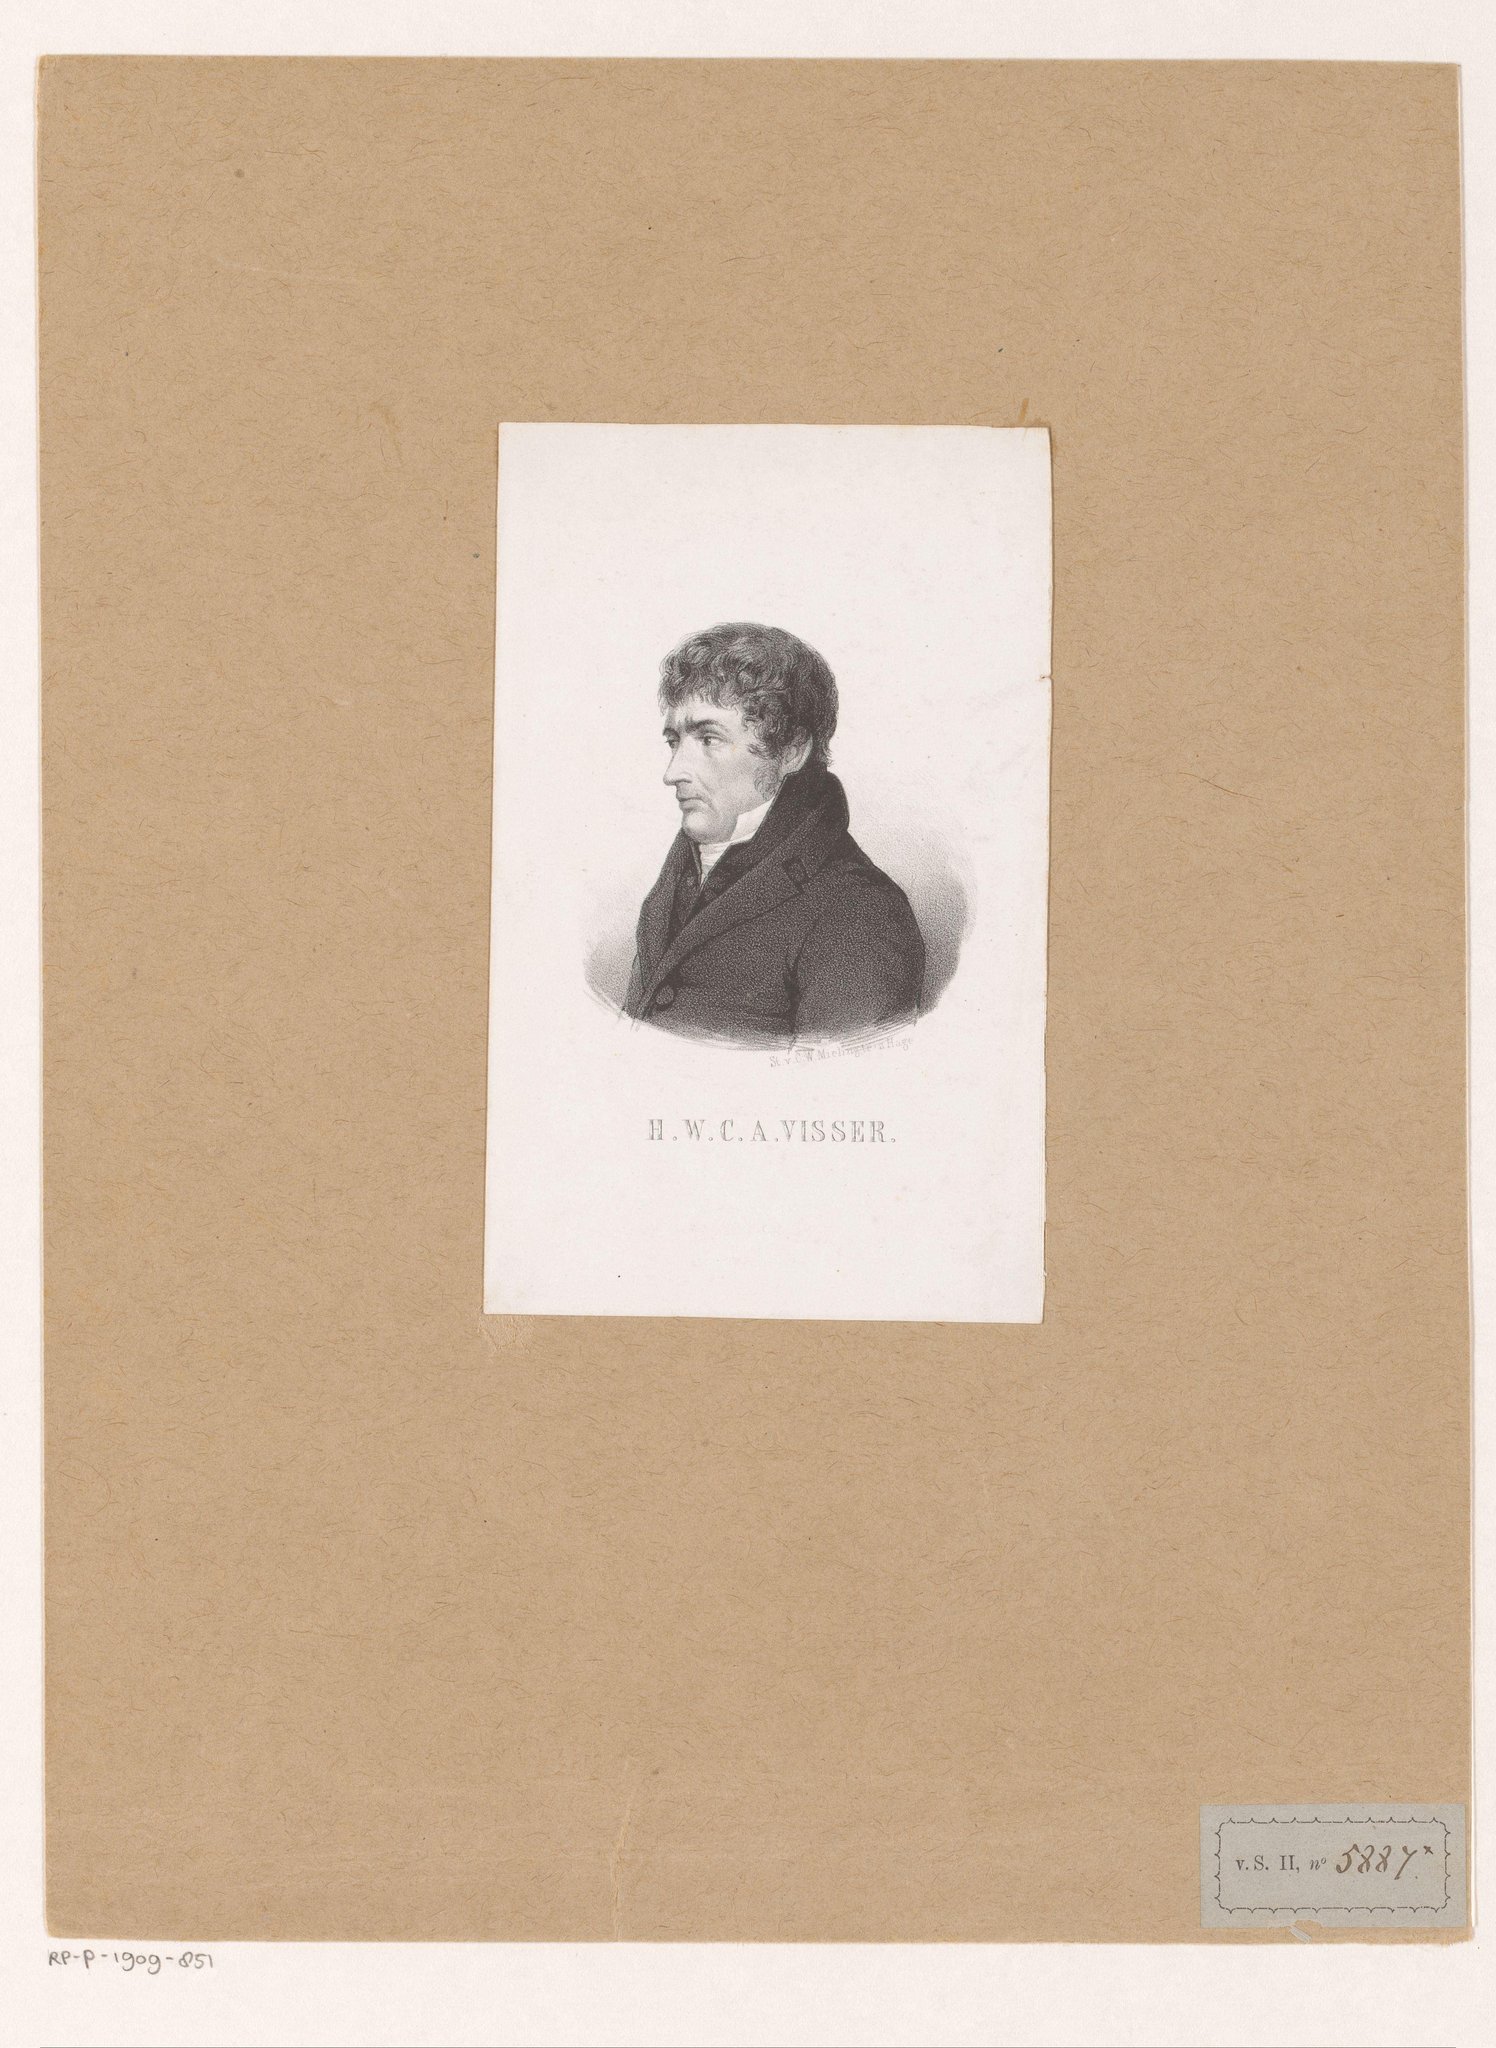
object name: print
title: Portret van Hans Willem Cornelis Anne Visser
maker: Anonymous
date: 1845-1847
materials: paper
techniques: lithograph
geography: the hague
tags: historical persons (+ profile portrait)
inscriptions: collector's mark: Lugt 2228